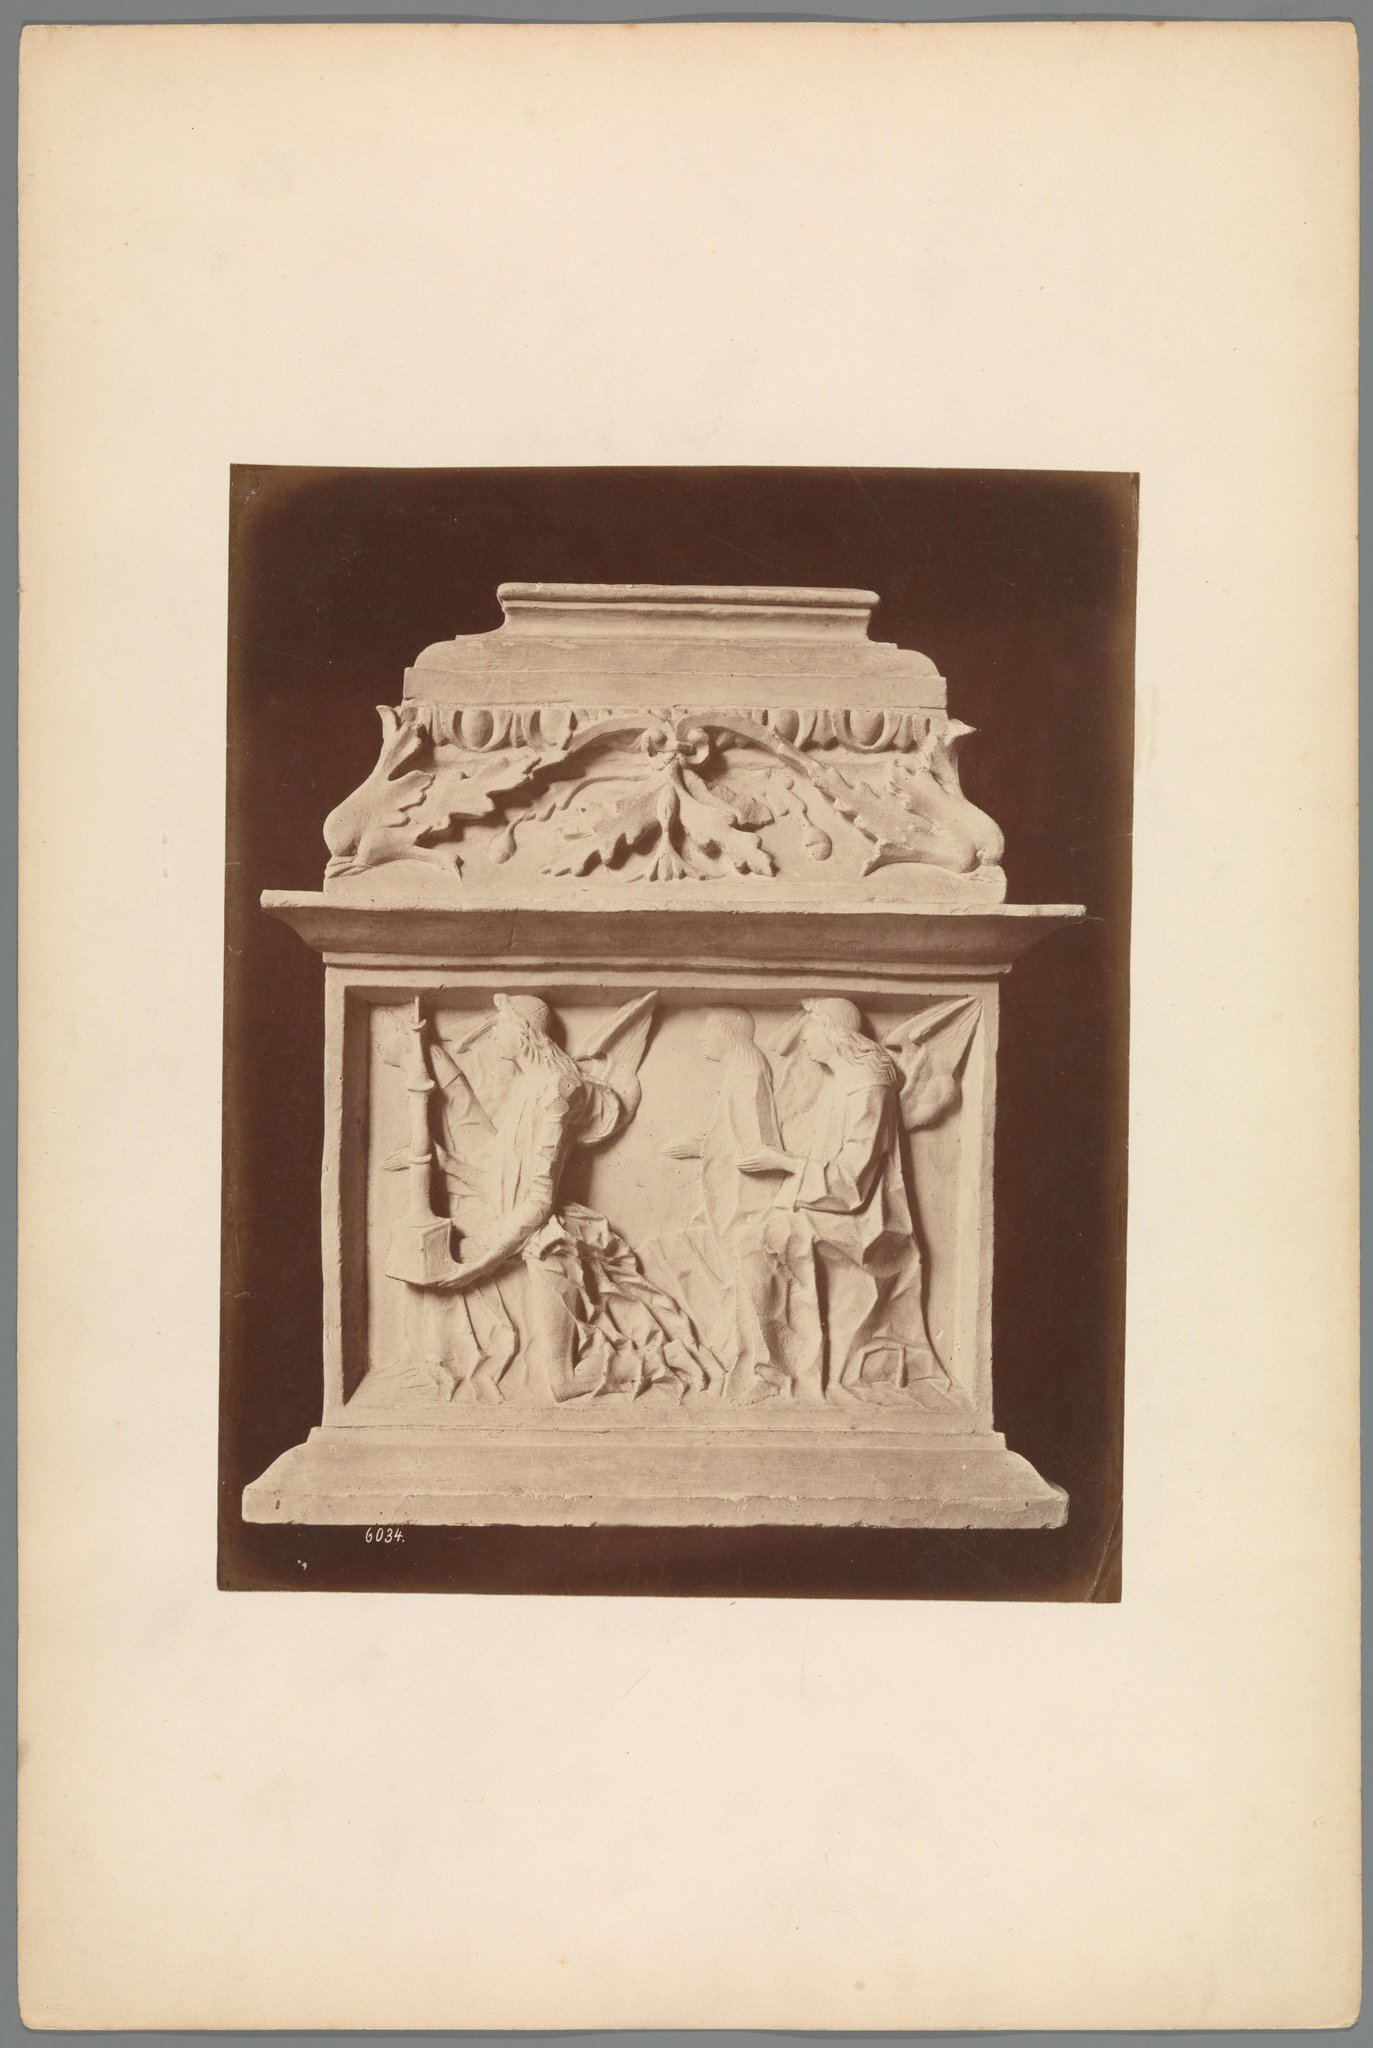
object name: photograph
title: Basement gedecoreerd met een reliëf met vier engelen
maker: Anonymous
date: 1875-1900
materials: cardboard, photographic support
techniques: albumen print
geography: europe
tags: base (~ column, pillar), angels, sculpture (+ relief ~ sculpture), europe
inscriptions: number: ‘6034.’, collector's mark: Lugt 3937